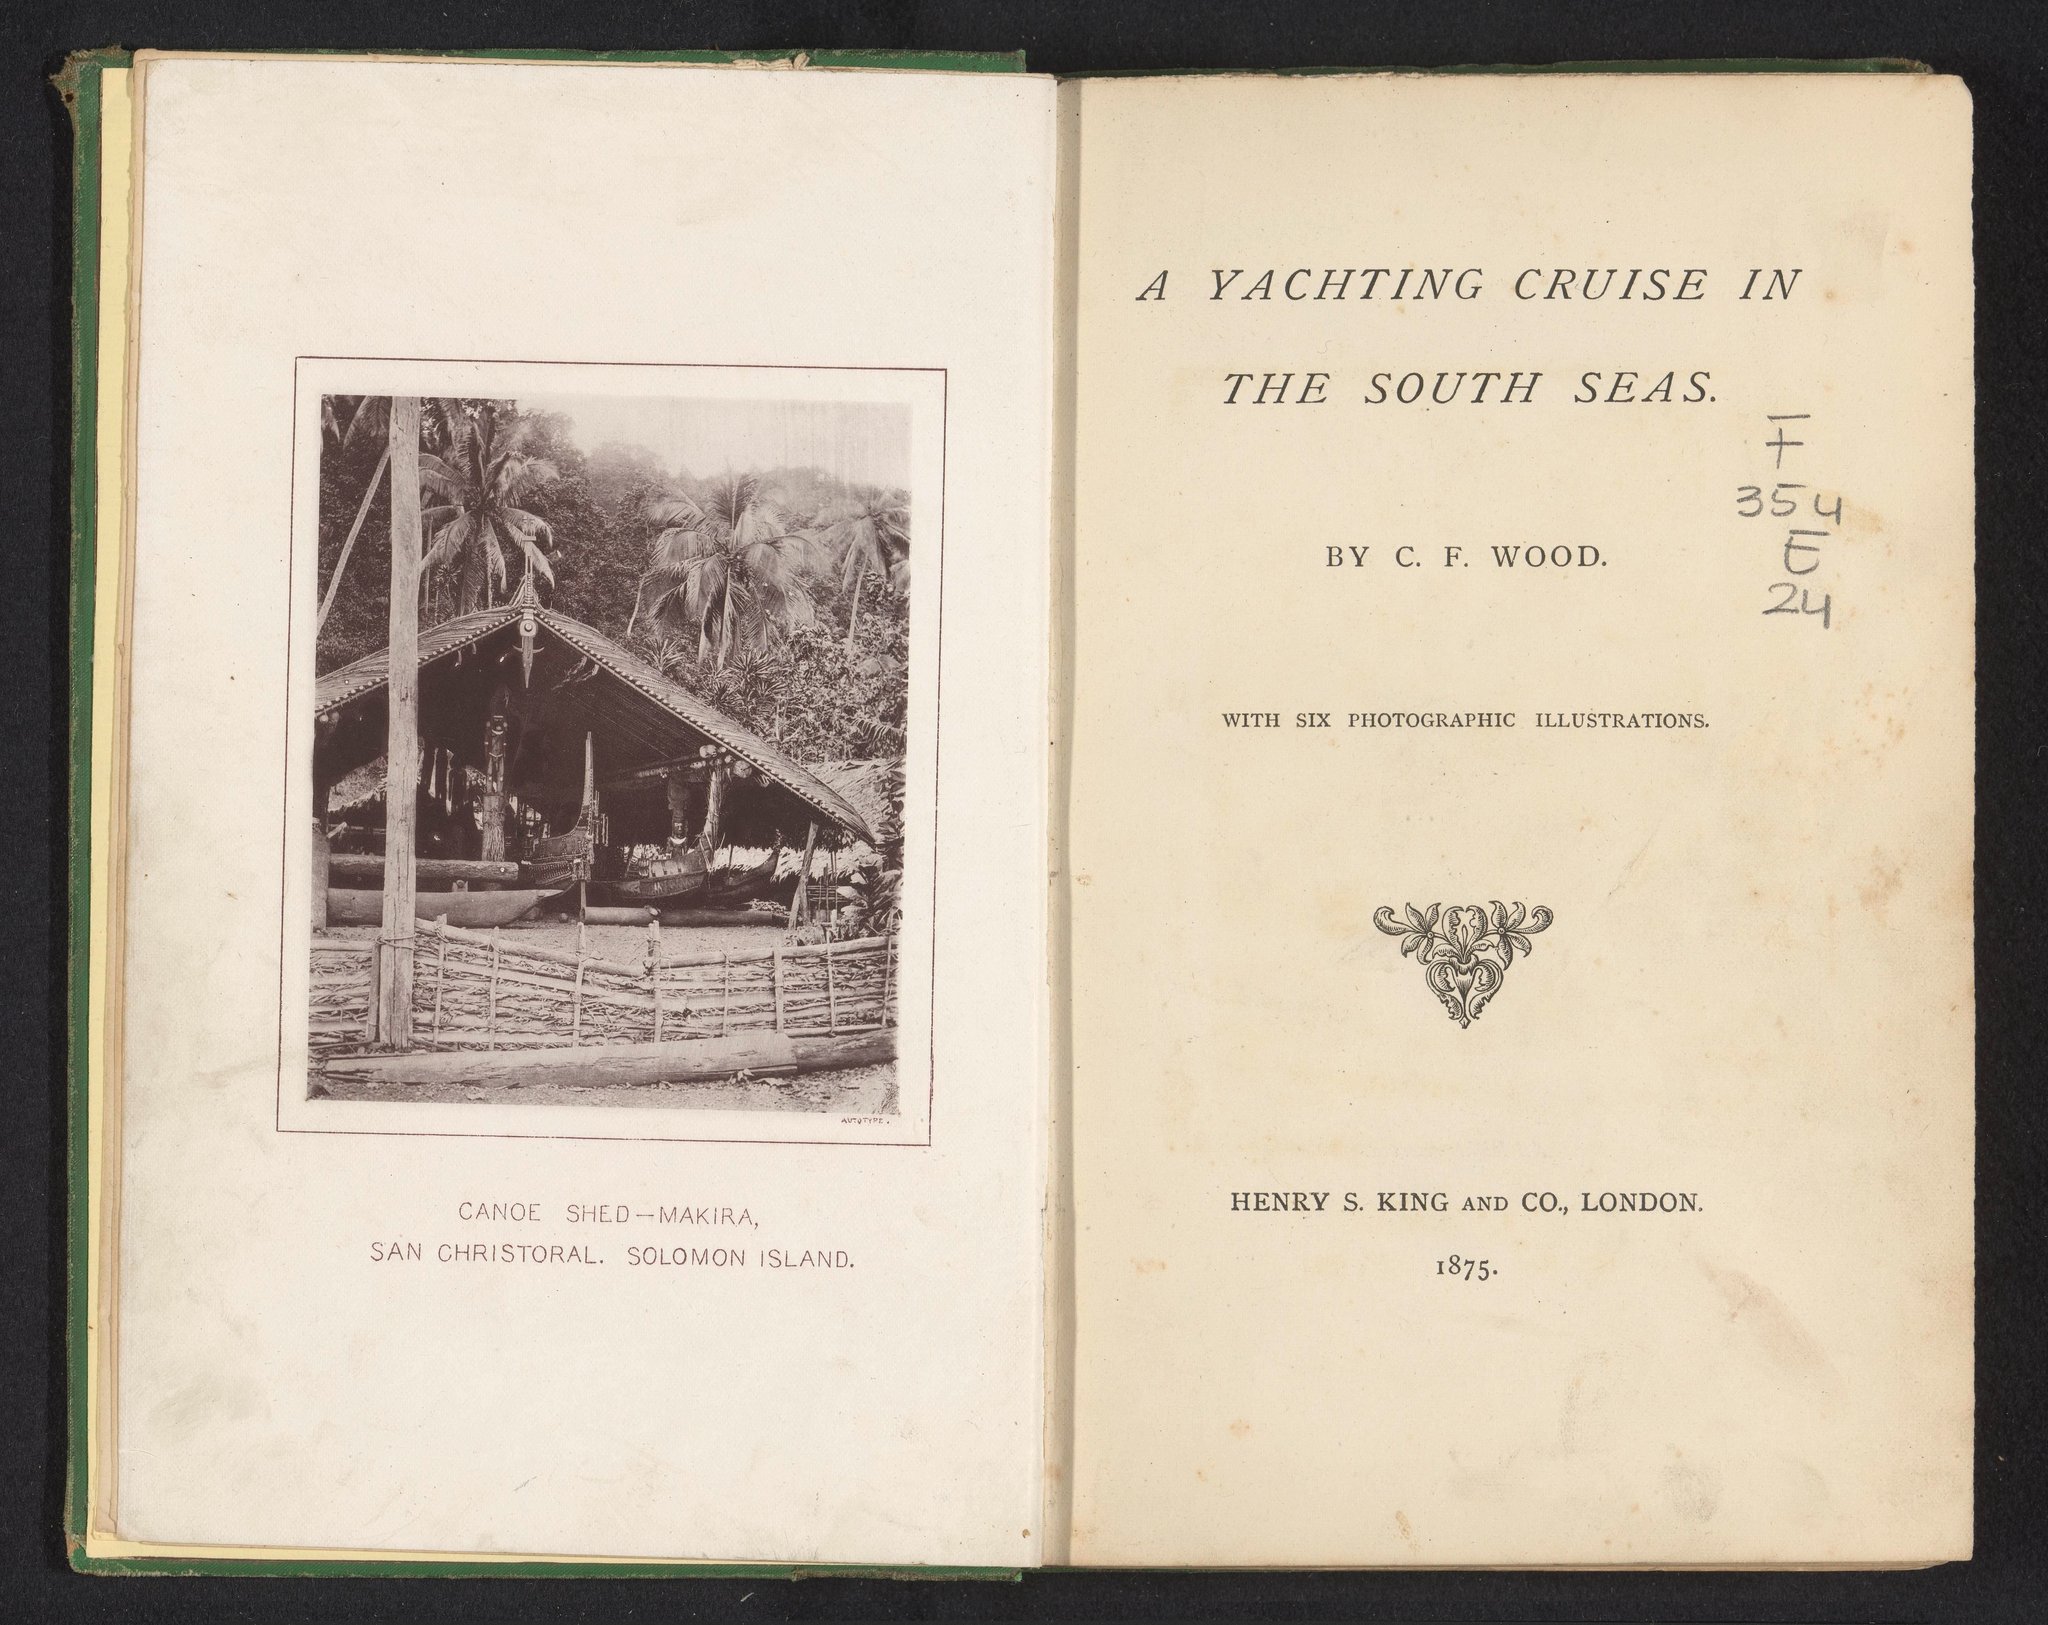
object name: photomechanical print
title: Kano's onder een afdak in Makira op San Cristobal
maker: george smith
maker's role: fotograaf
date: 1865-1875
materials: paper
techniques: photograph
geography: solomon islands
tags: rowing-boat, canoe, etc.